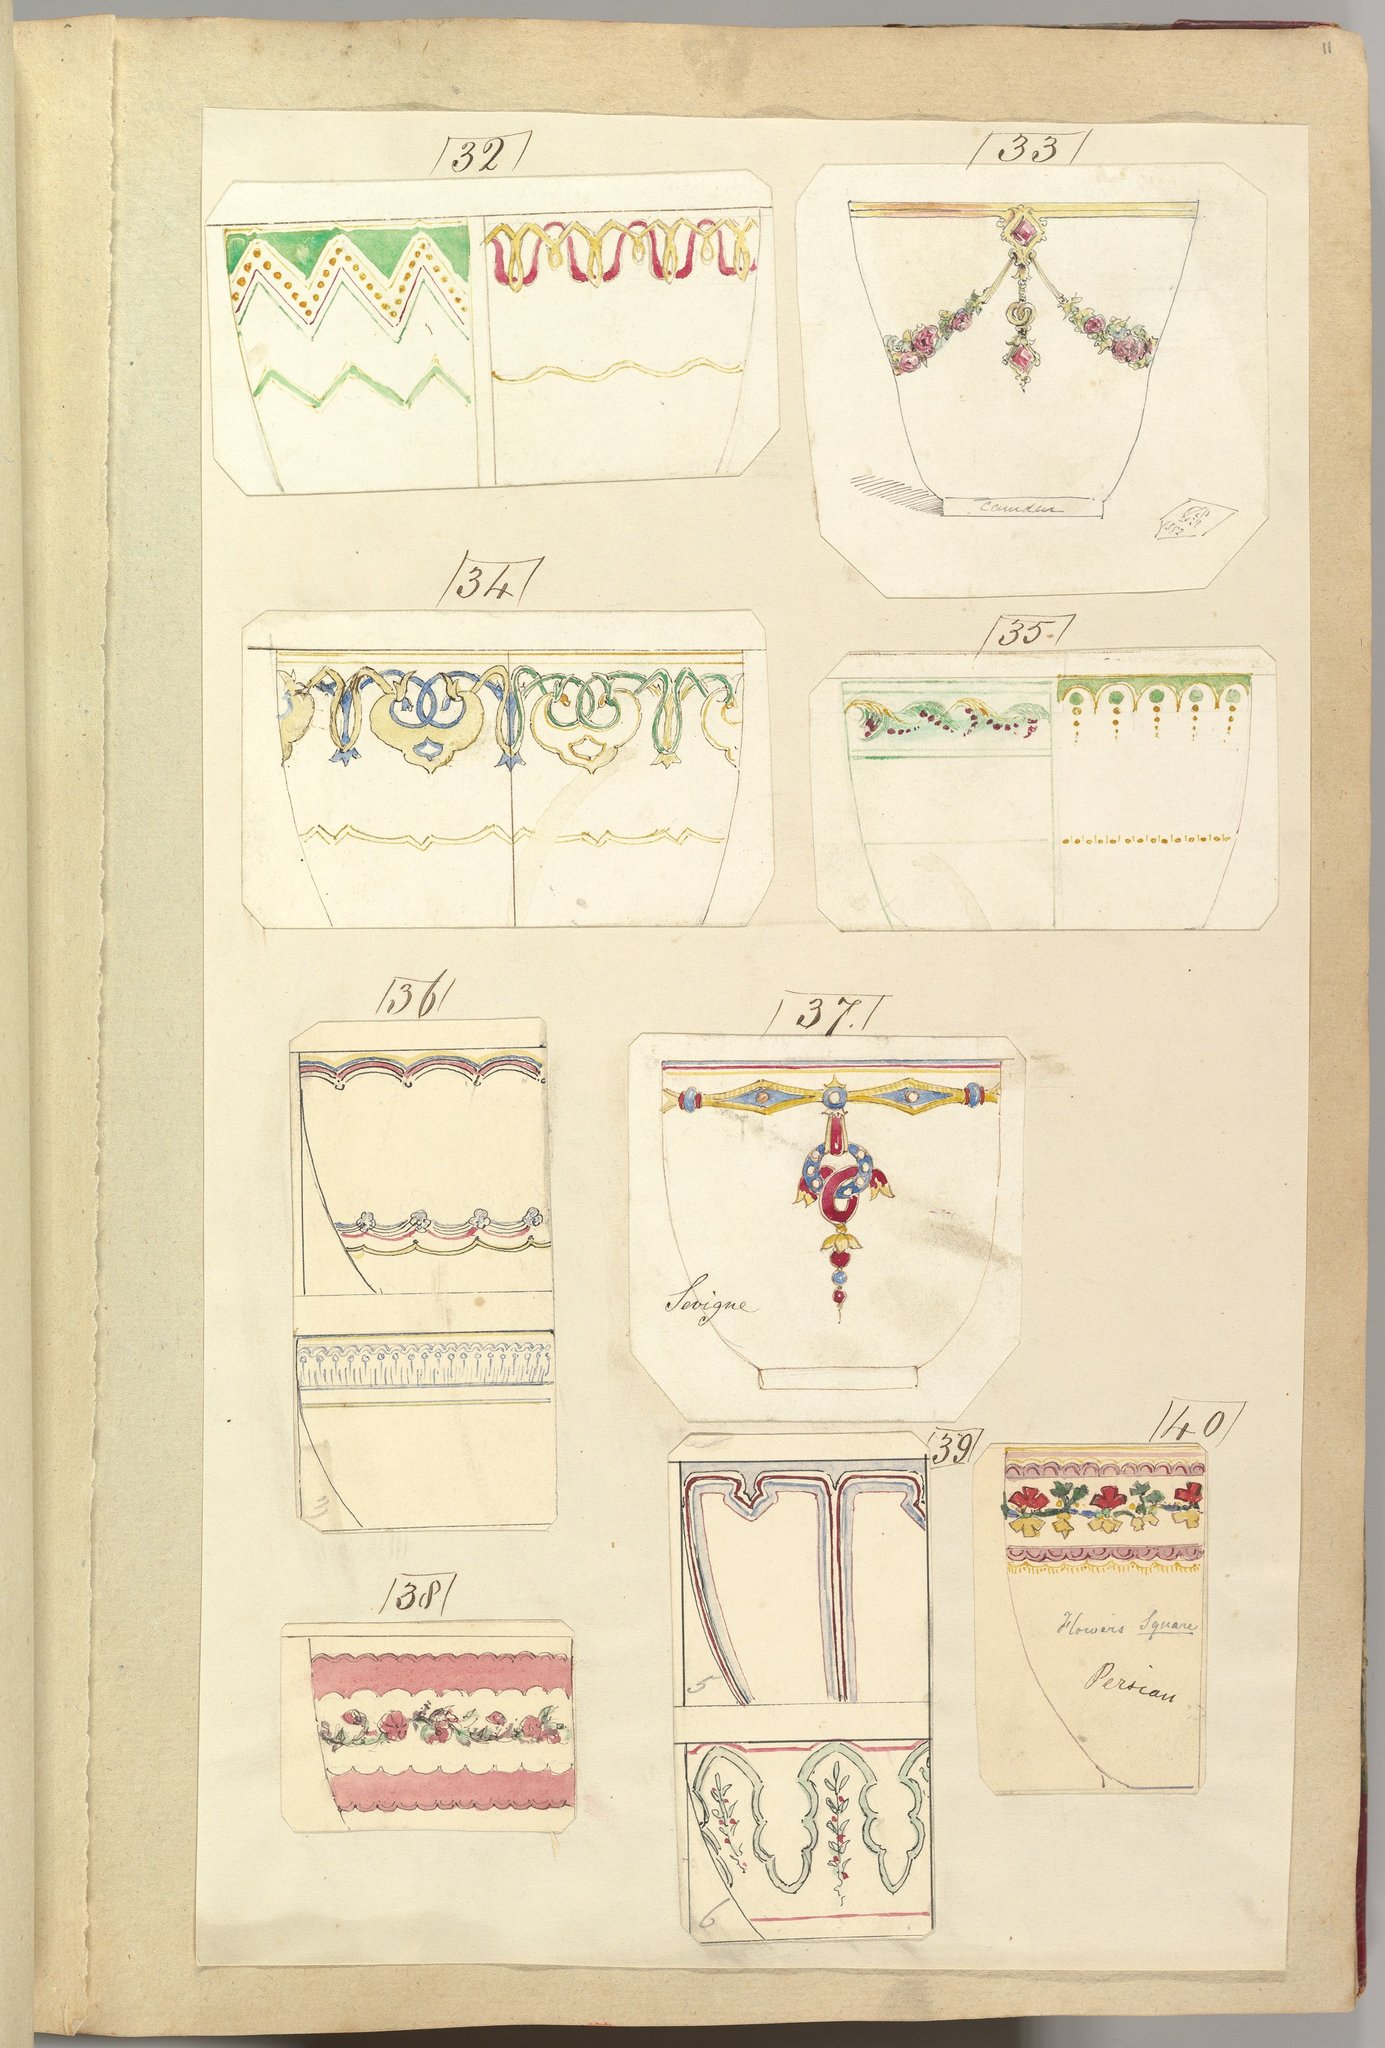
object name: drawing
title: Fourteen Designs for Decorated Cups, including "Camden", Sevigne" and "Persian" Patterns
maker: alfred henry forrester [alfred crowquill]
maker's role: artist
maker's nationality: british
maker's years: 1804-1872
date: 1852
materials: ink, watercolor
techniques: pen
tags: cups